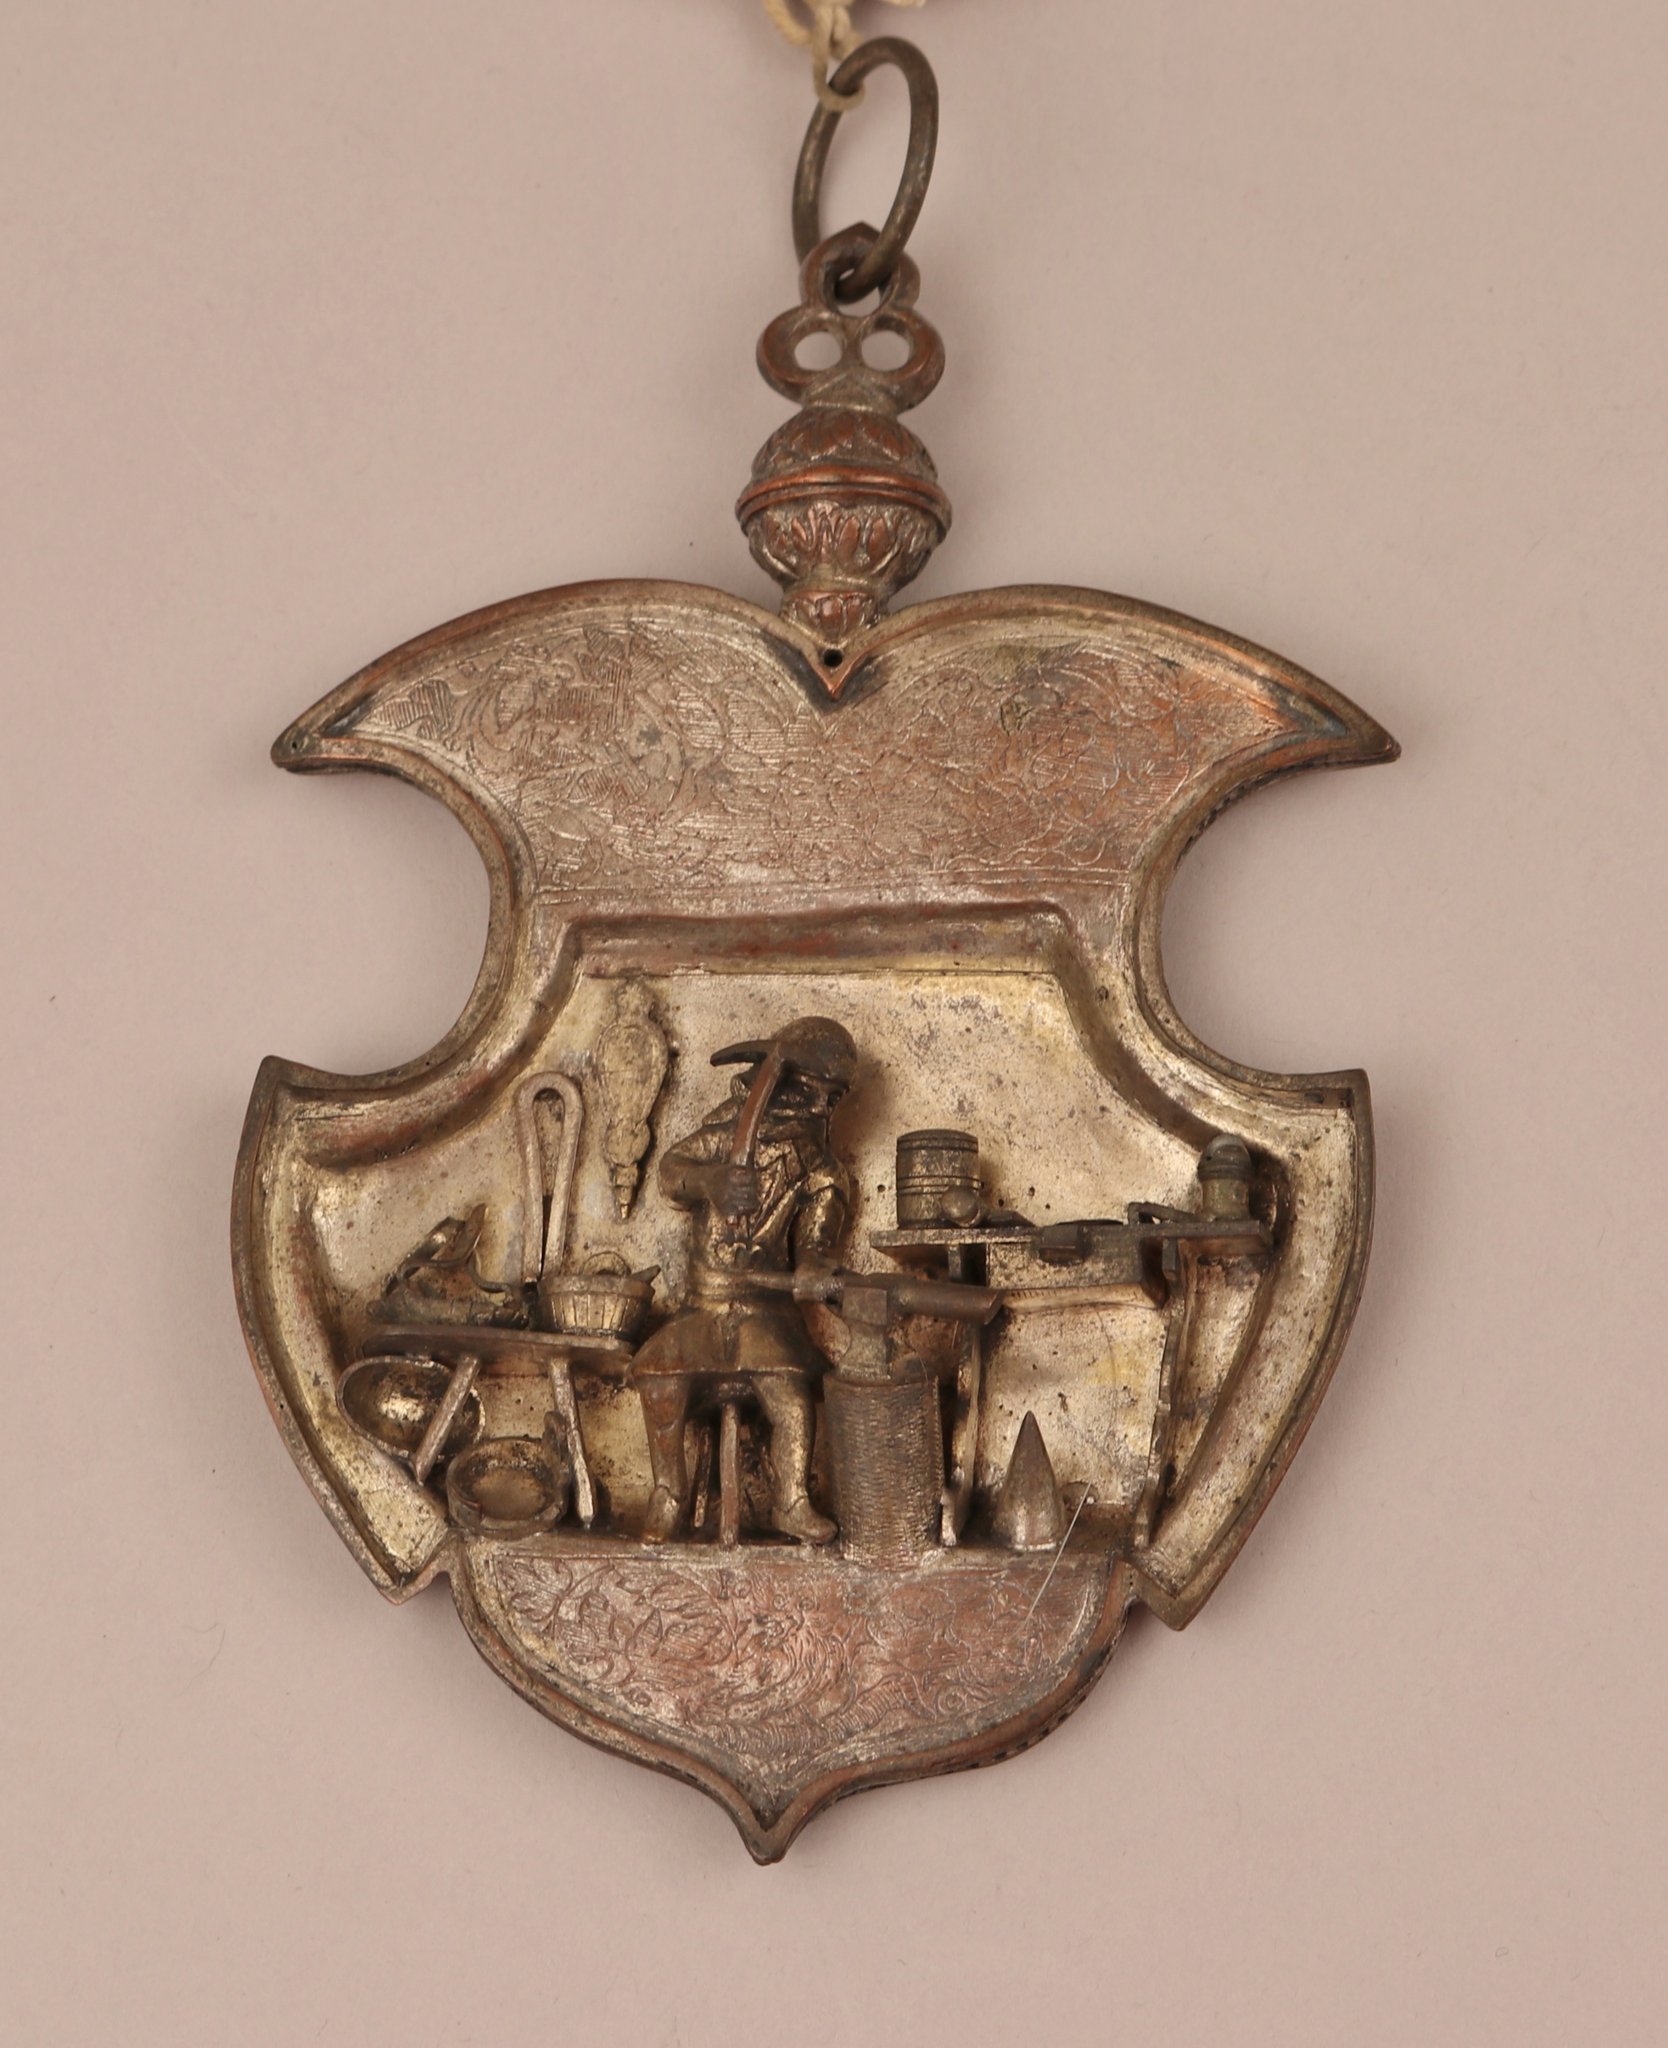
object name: badge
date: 1801-1900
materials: metal, silver